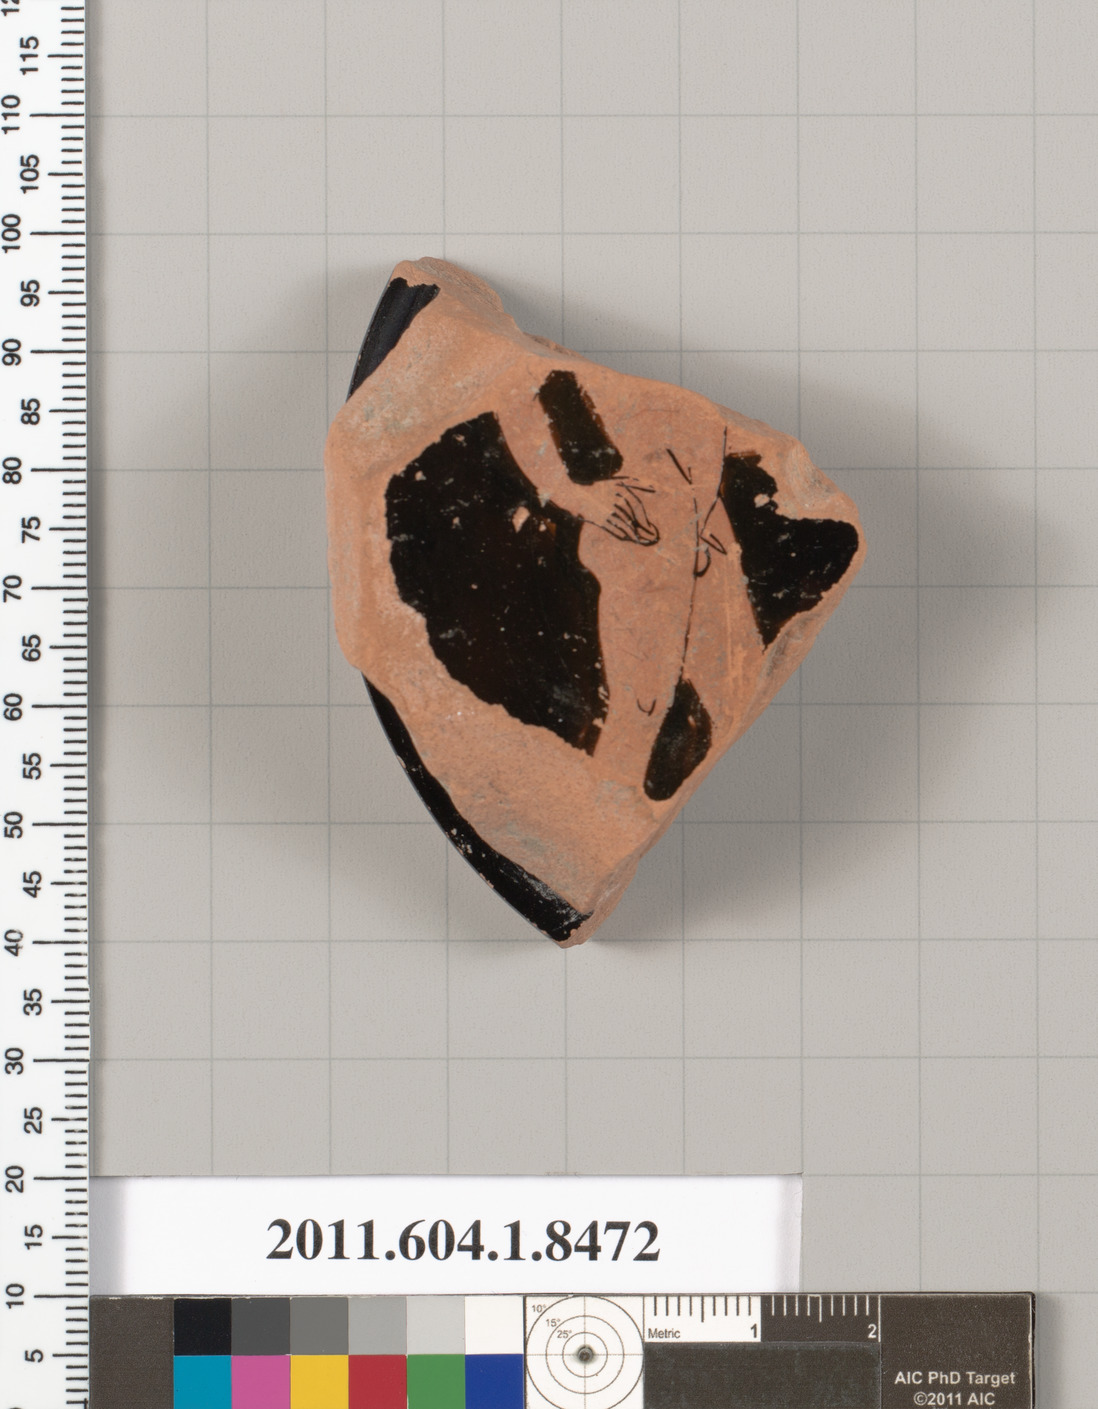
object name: kylix fragment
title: Terracotta fragment of a stemless kylix (drinking cup)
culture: greek, attic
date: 475-451 BCE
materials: terracotta